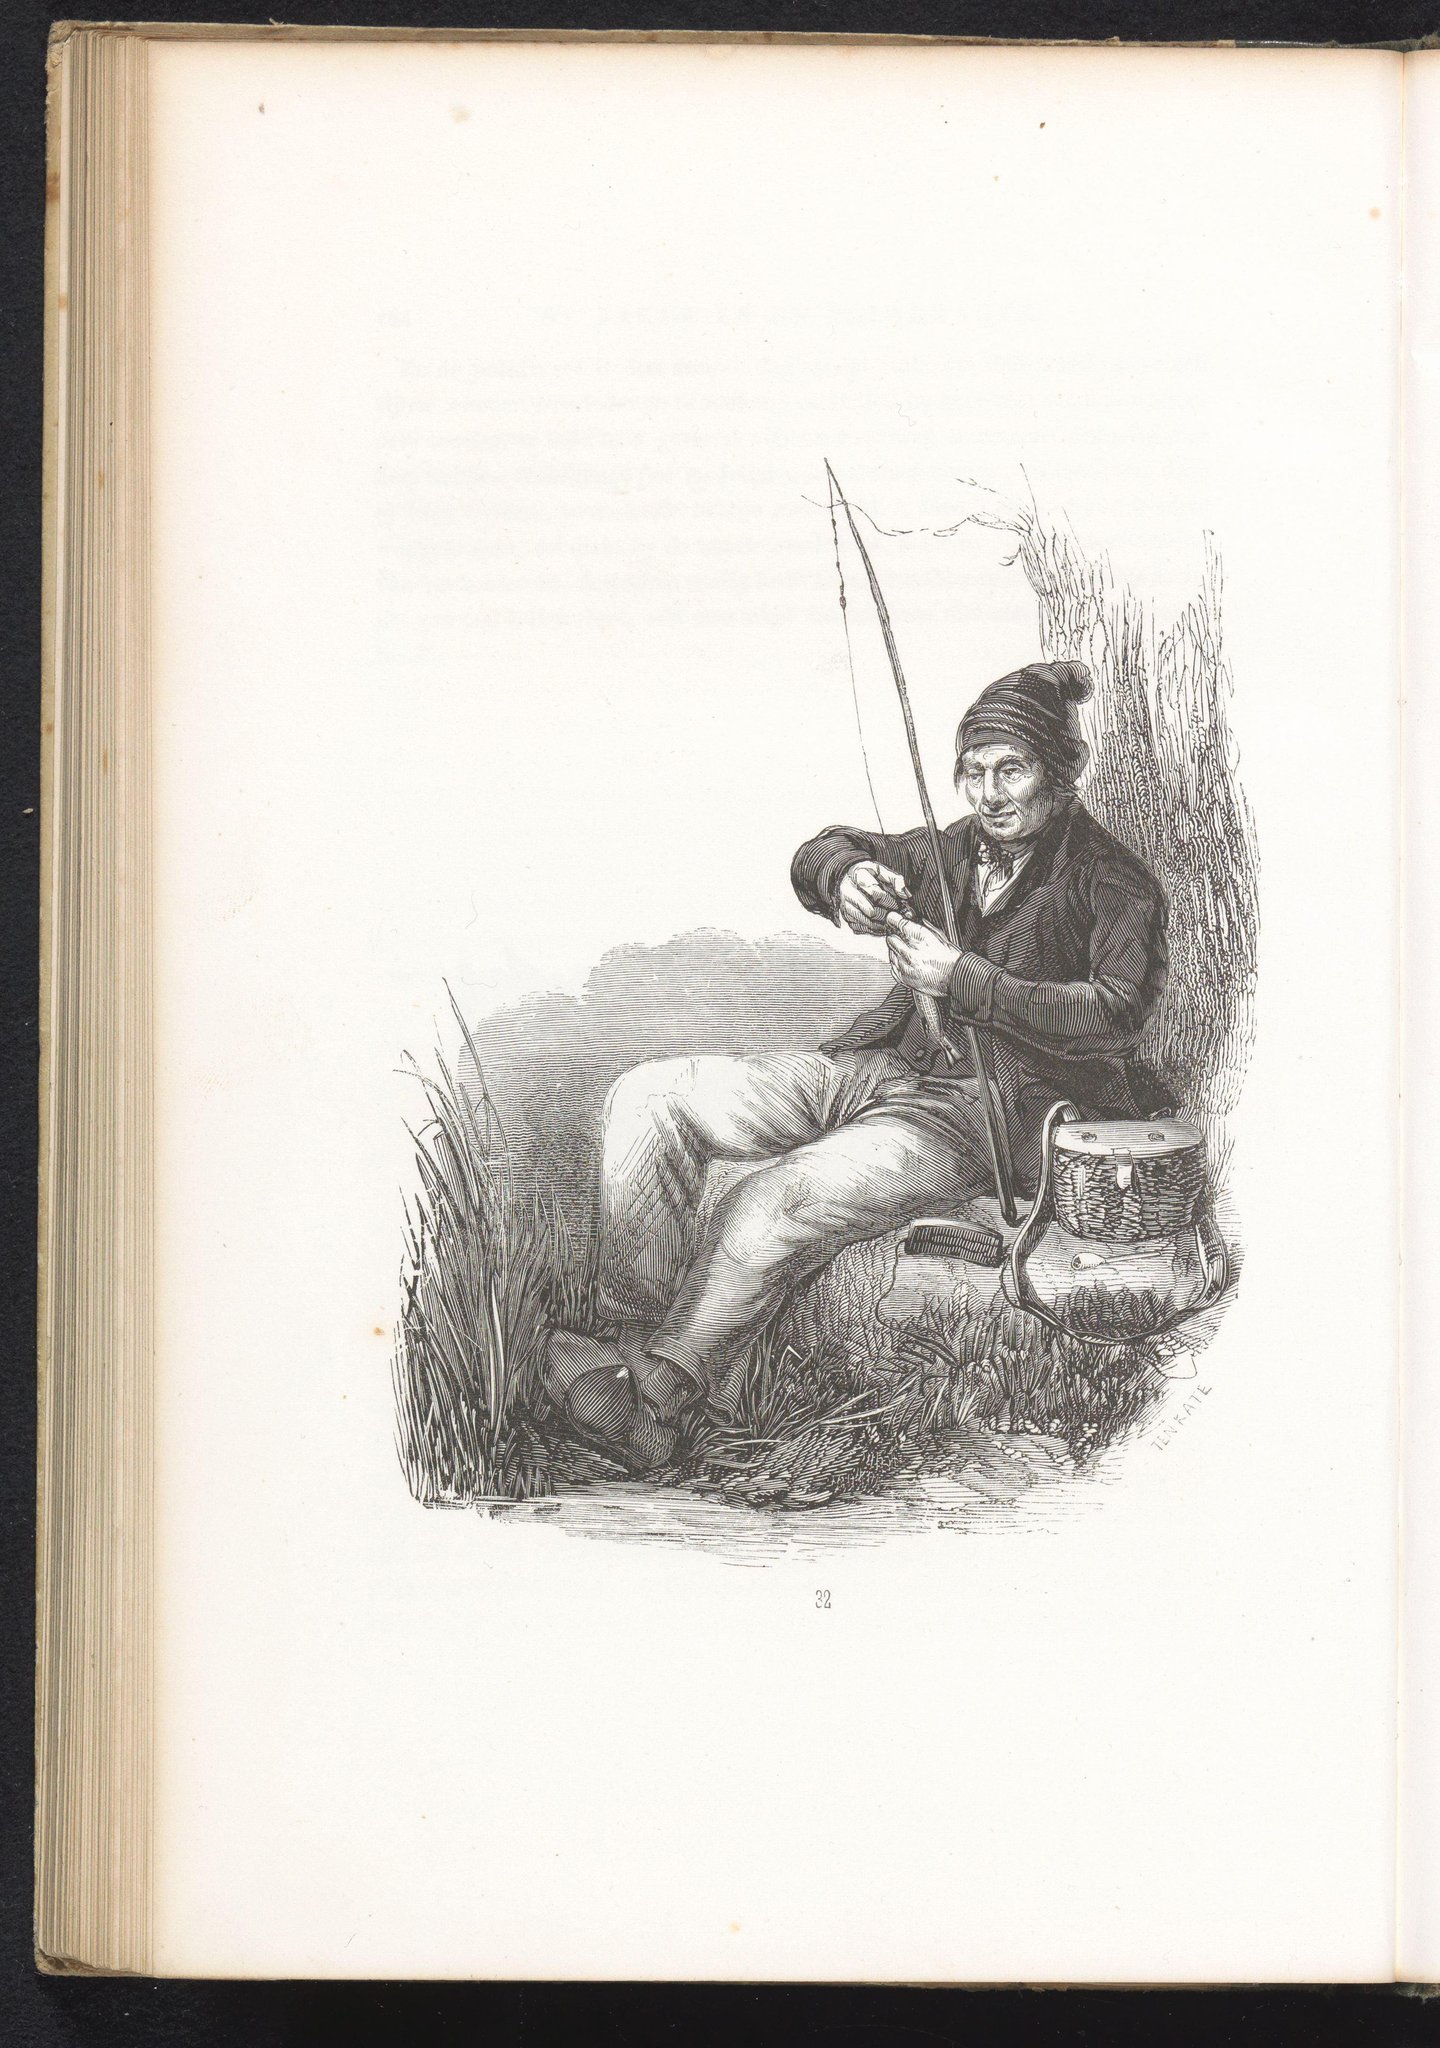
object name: book illustration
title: De Leidse peueraar, 1840-1841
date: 1841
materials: paper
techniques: letterpress printing, engraving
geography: the hague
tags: professional clothes, fisherman, leiden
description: De Leidse peueraar (peurder, iemand die vist met een peur, een verzwaarde lijn waaraan een tros wormen geknoopt is). Man met hengel zittend aan de waterkant. Genummerd: 32. Illustratie in het boek 'De Nederlanden: karakterschetsen, kleederdrachten, houding en voorkomen van verschillende standen', een boek met karakterschetsen, beroepen en klederdrachten van Nederlandse volkstypen uit 1841.